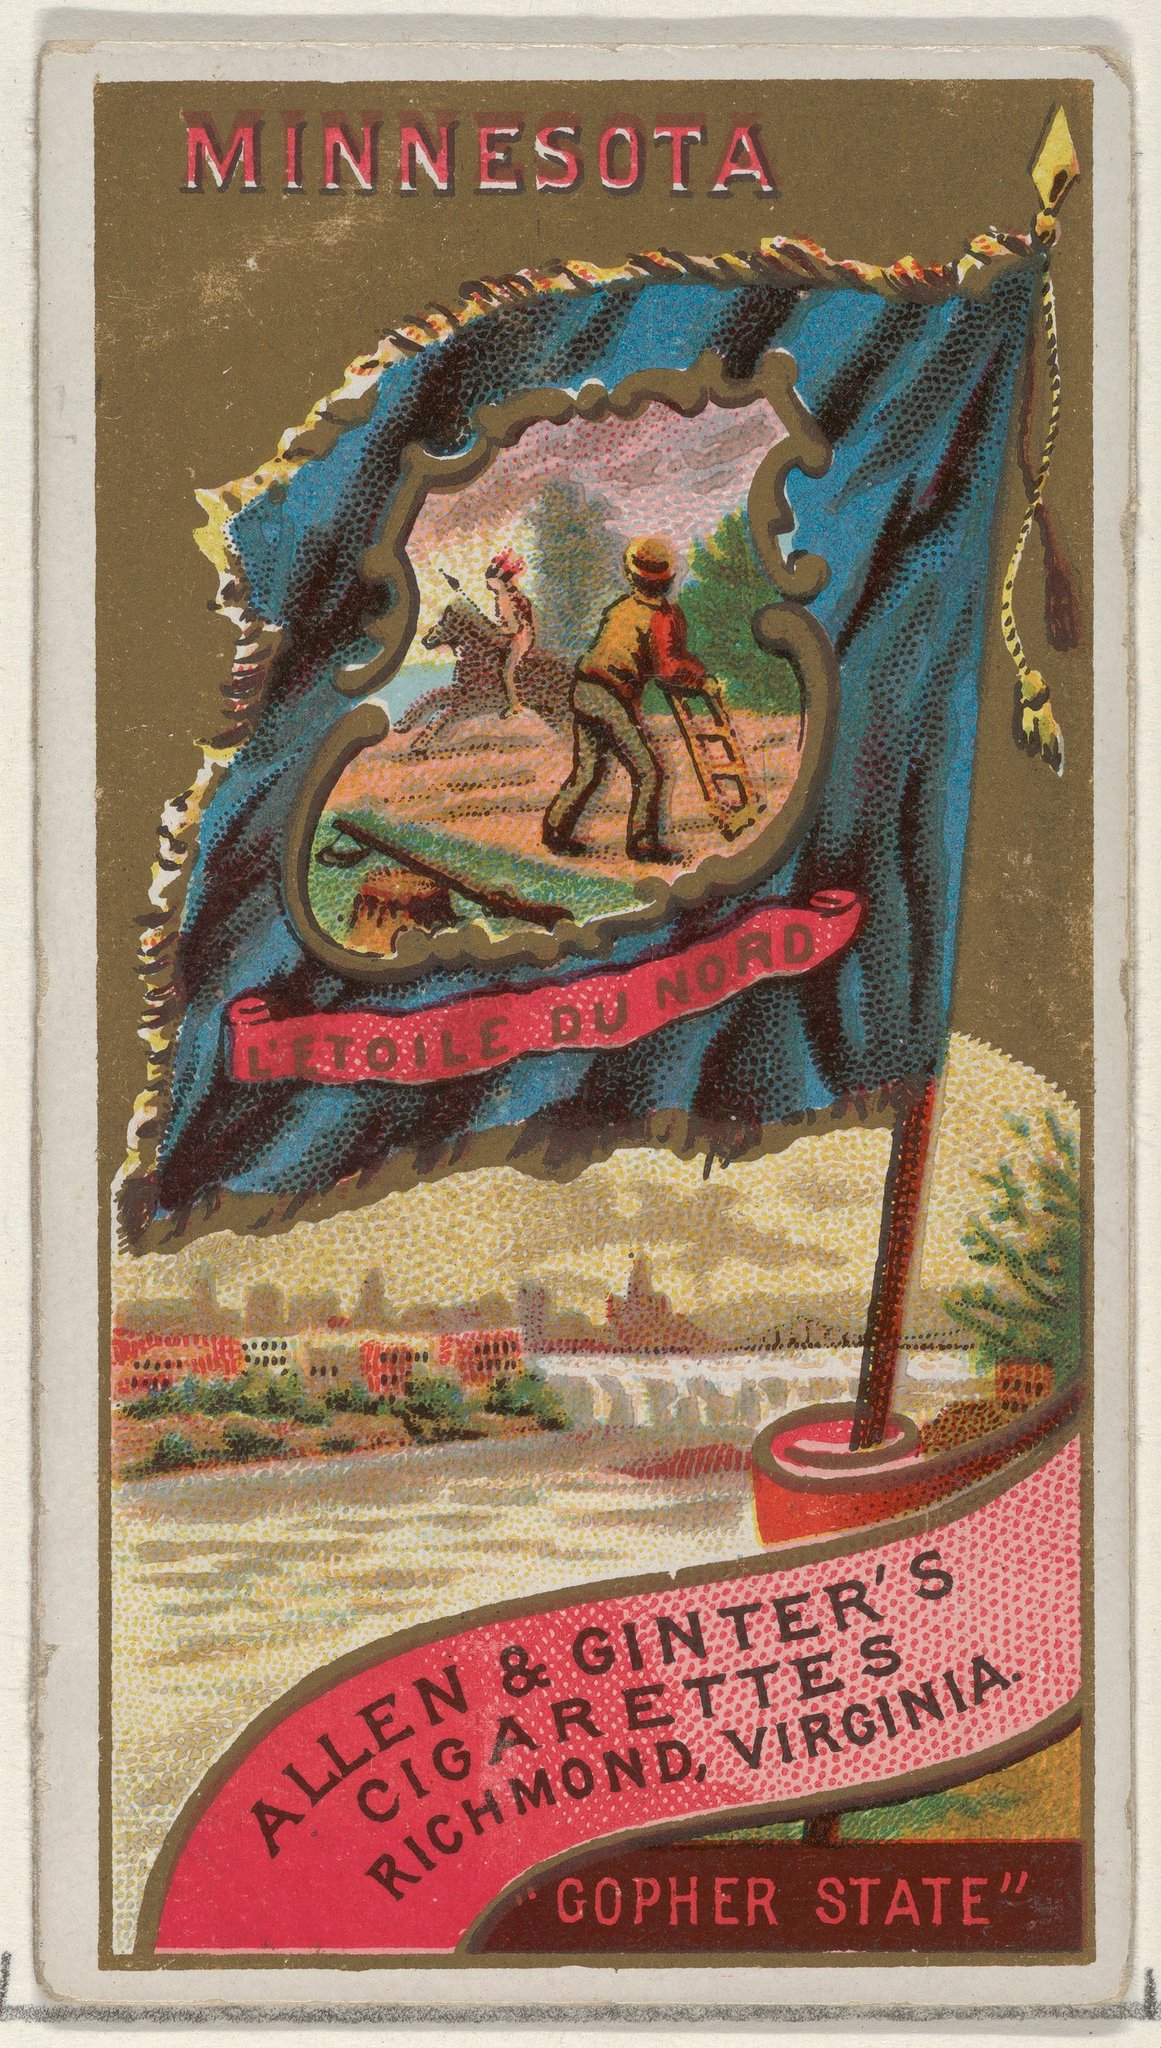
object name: print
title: Minnesota, from Flags of the States and Territories (N11) for Allen & Ginter Cigarettes Brands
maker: allen & ginter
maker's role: publisher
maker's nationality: american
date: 1888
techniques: color lithograph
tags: flags